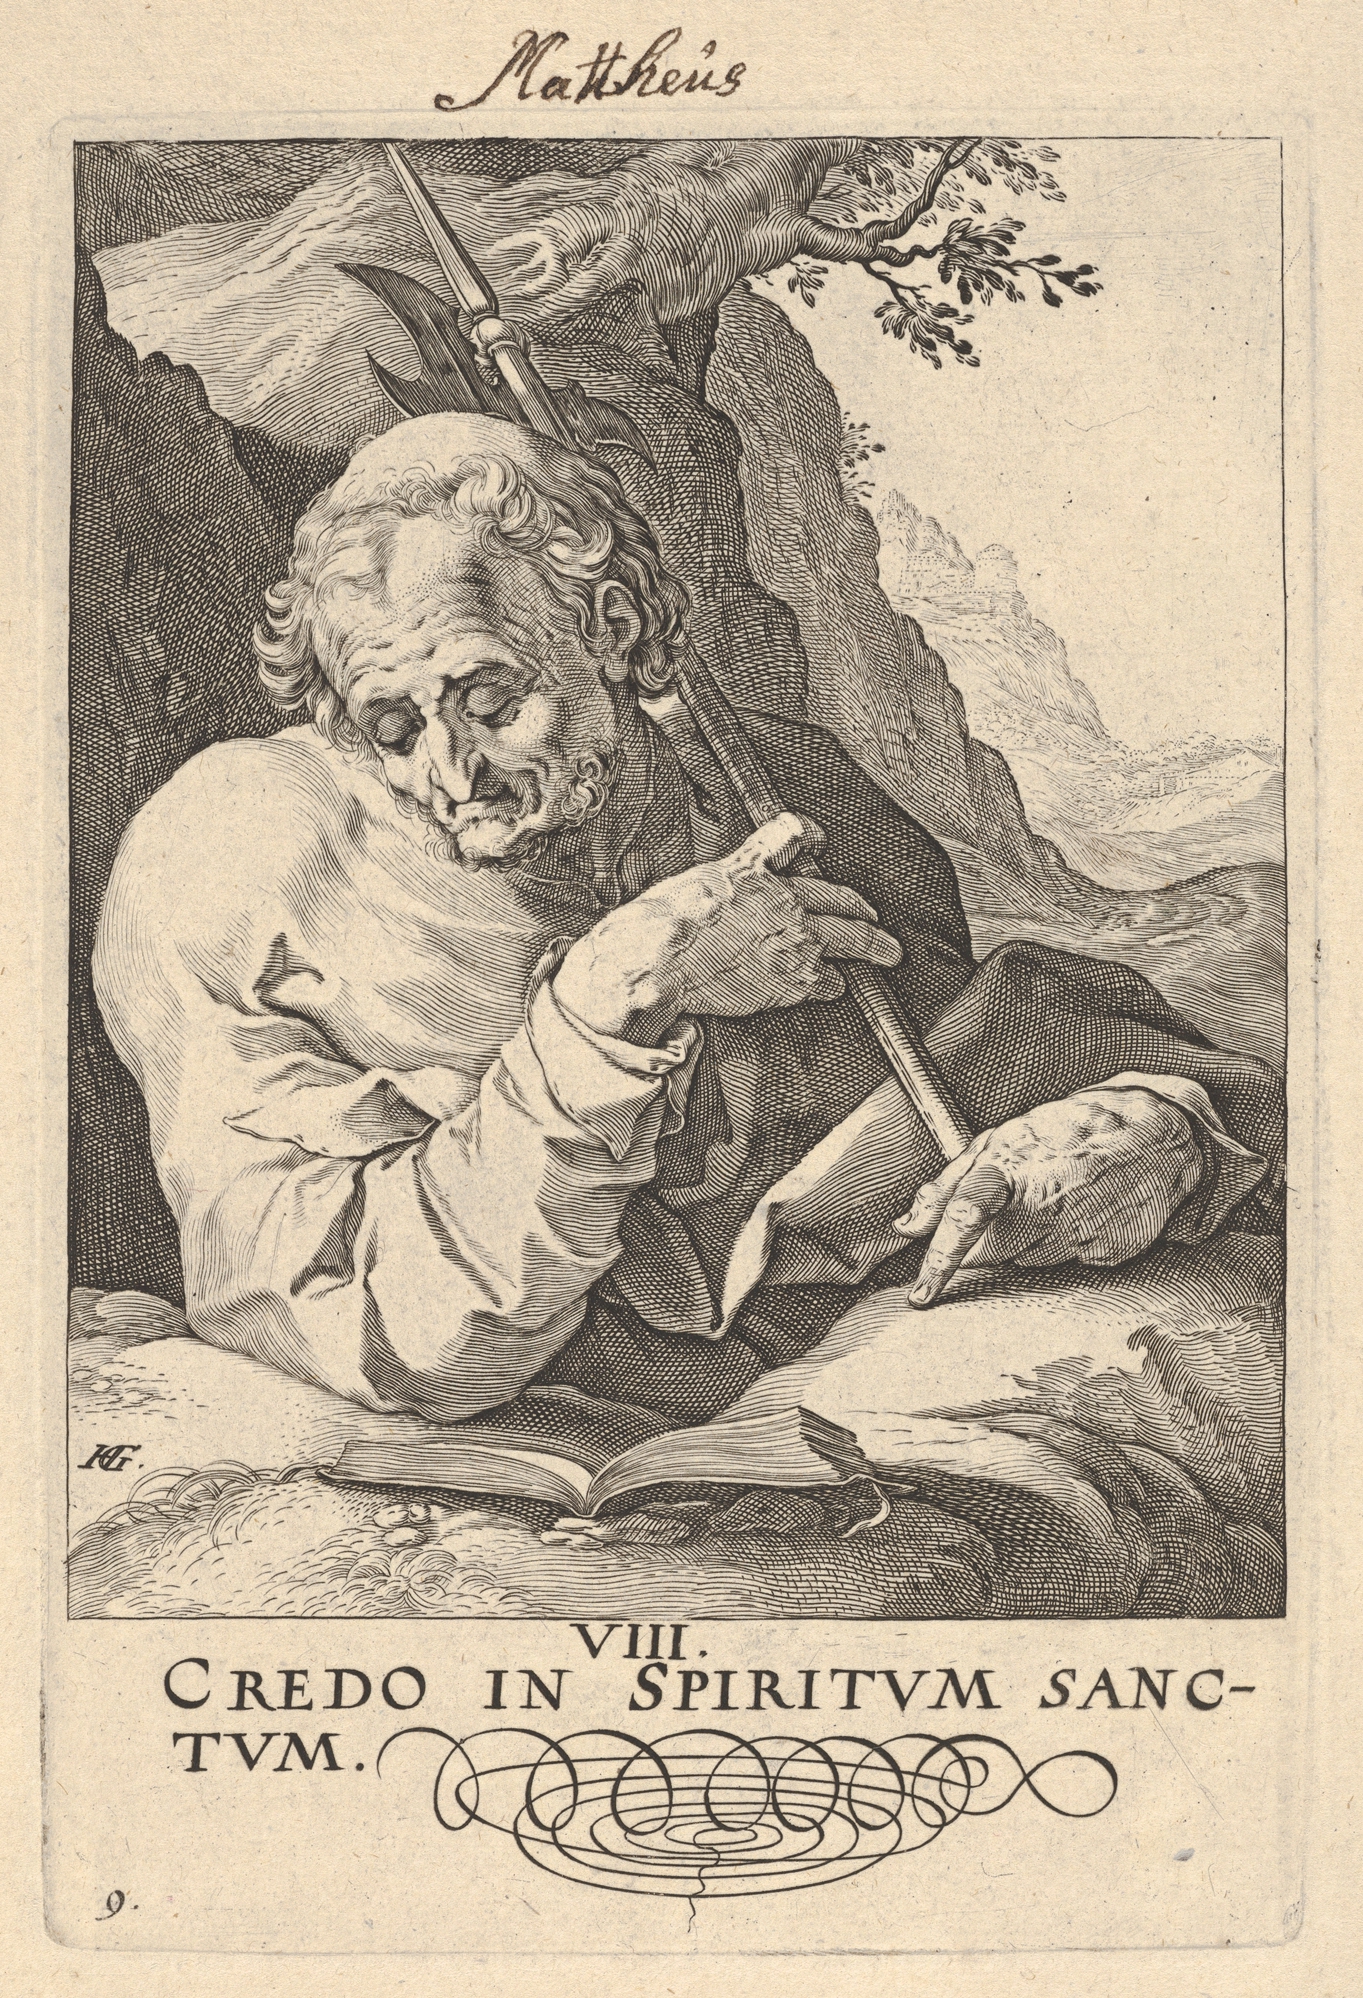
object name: print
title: St. Matthew, from "Christ, the Apostles and St. Paul with the Creed"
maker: hendrick goltzius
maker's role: artist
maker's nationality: netherlandish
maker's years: 1558-1617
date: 1589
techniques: engraving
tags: books,apostles,saint matthew